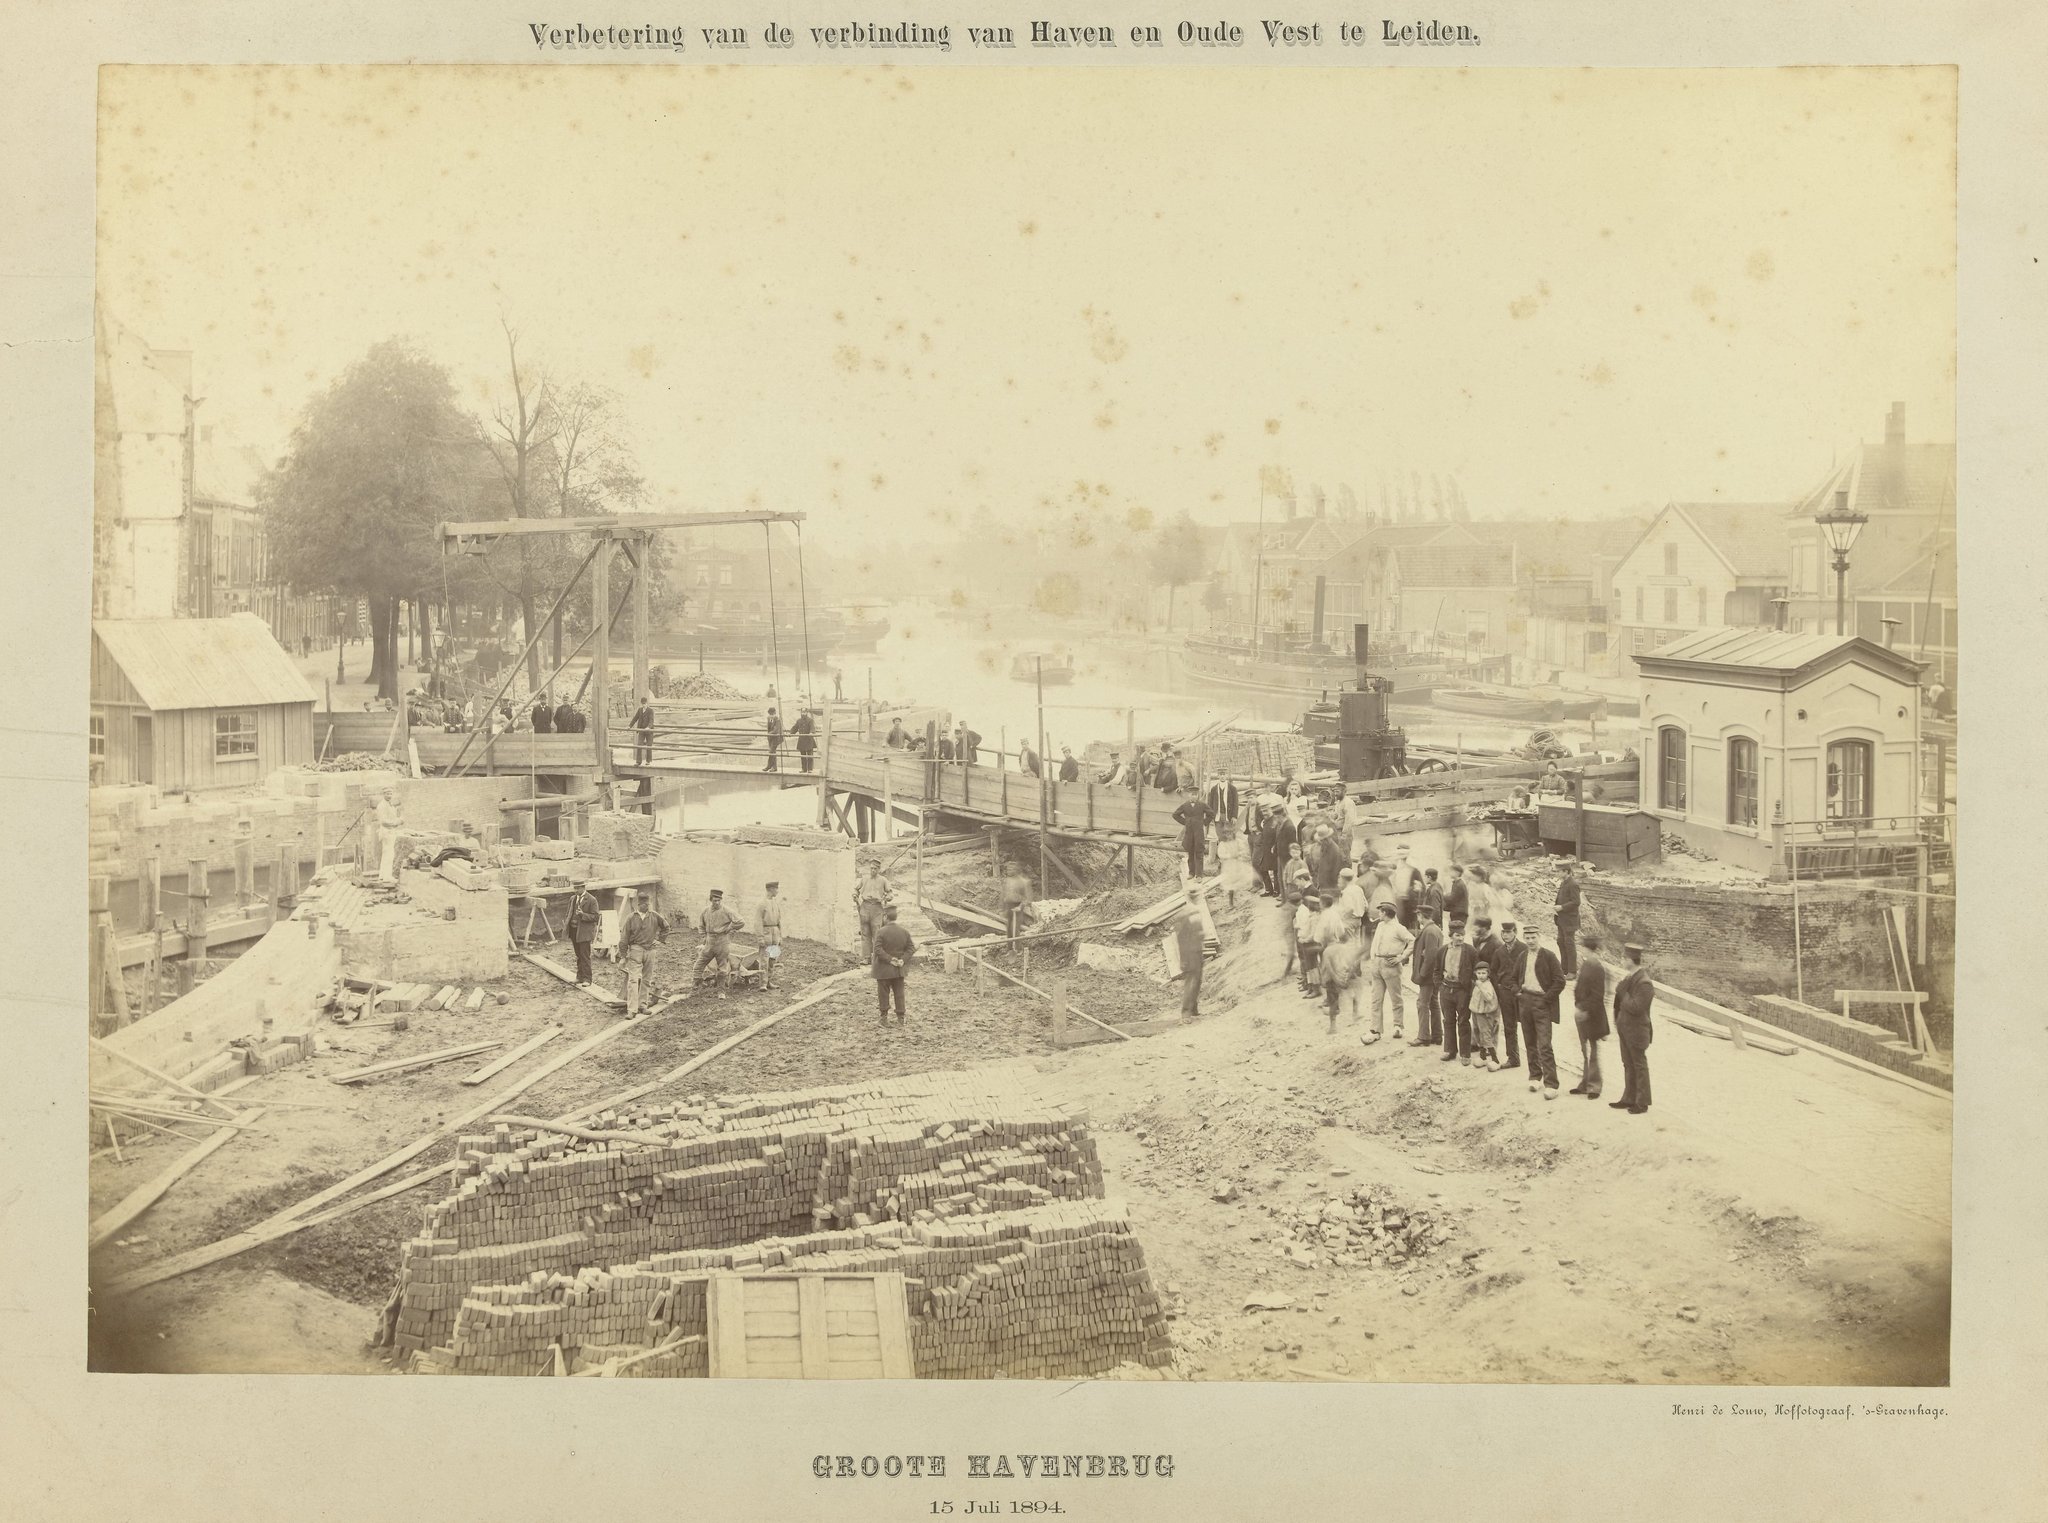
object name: photograph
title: Werkzaamheden aan de Grote Havenbrug te Leiden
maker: henri de louw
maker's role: fotograaf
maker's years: 1851-1944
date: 1894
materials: cardboard, photographic support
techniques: albumen print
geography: the hague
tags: bridge in city across river, canal, etc., leiden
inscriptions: date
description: Werkzaamheden aan de Grote Havenbrug te Leiden in de tijdelijke situatie met de houten constructie voordat de dubbele ophaalbrug werd geplaatst in 1894-1895.